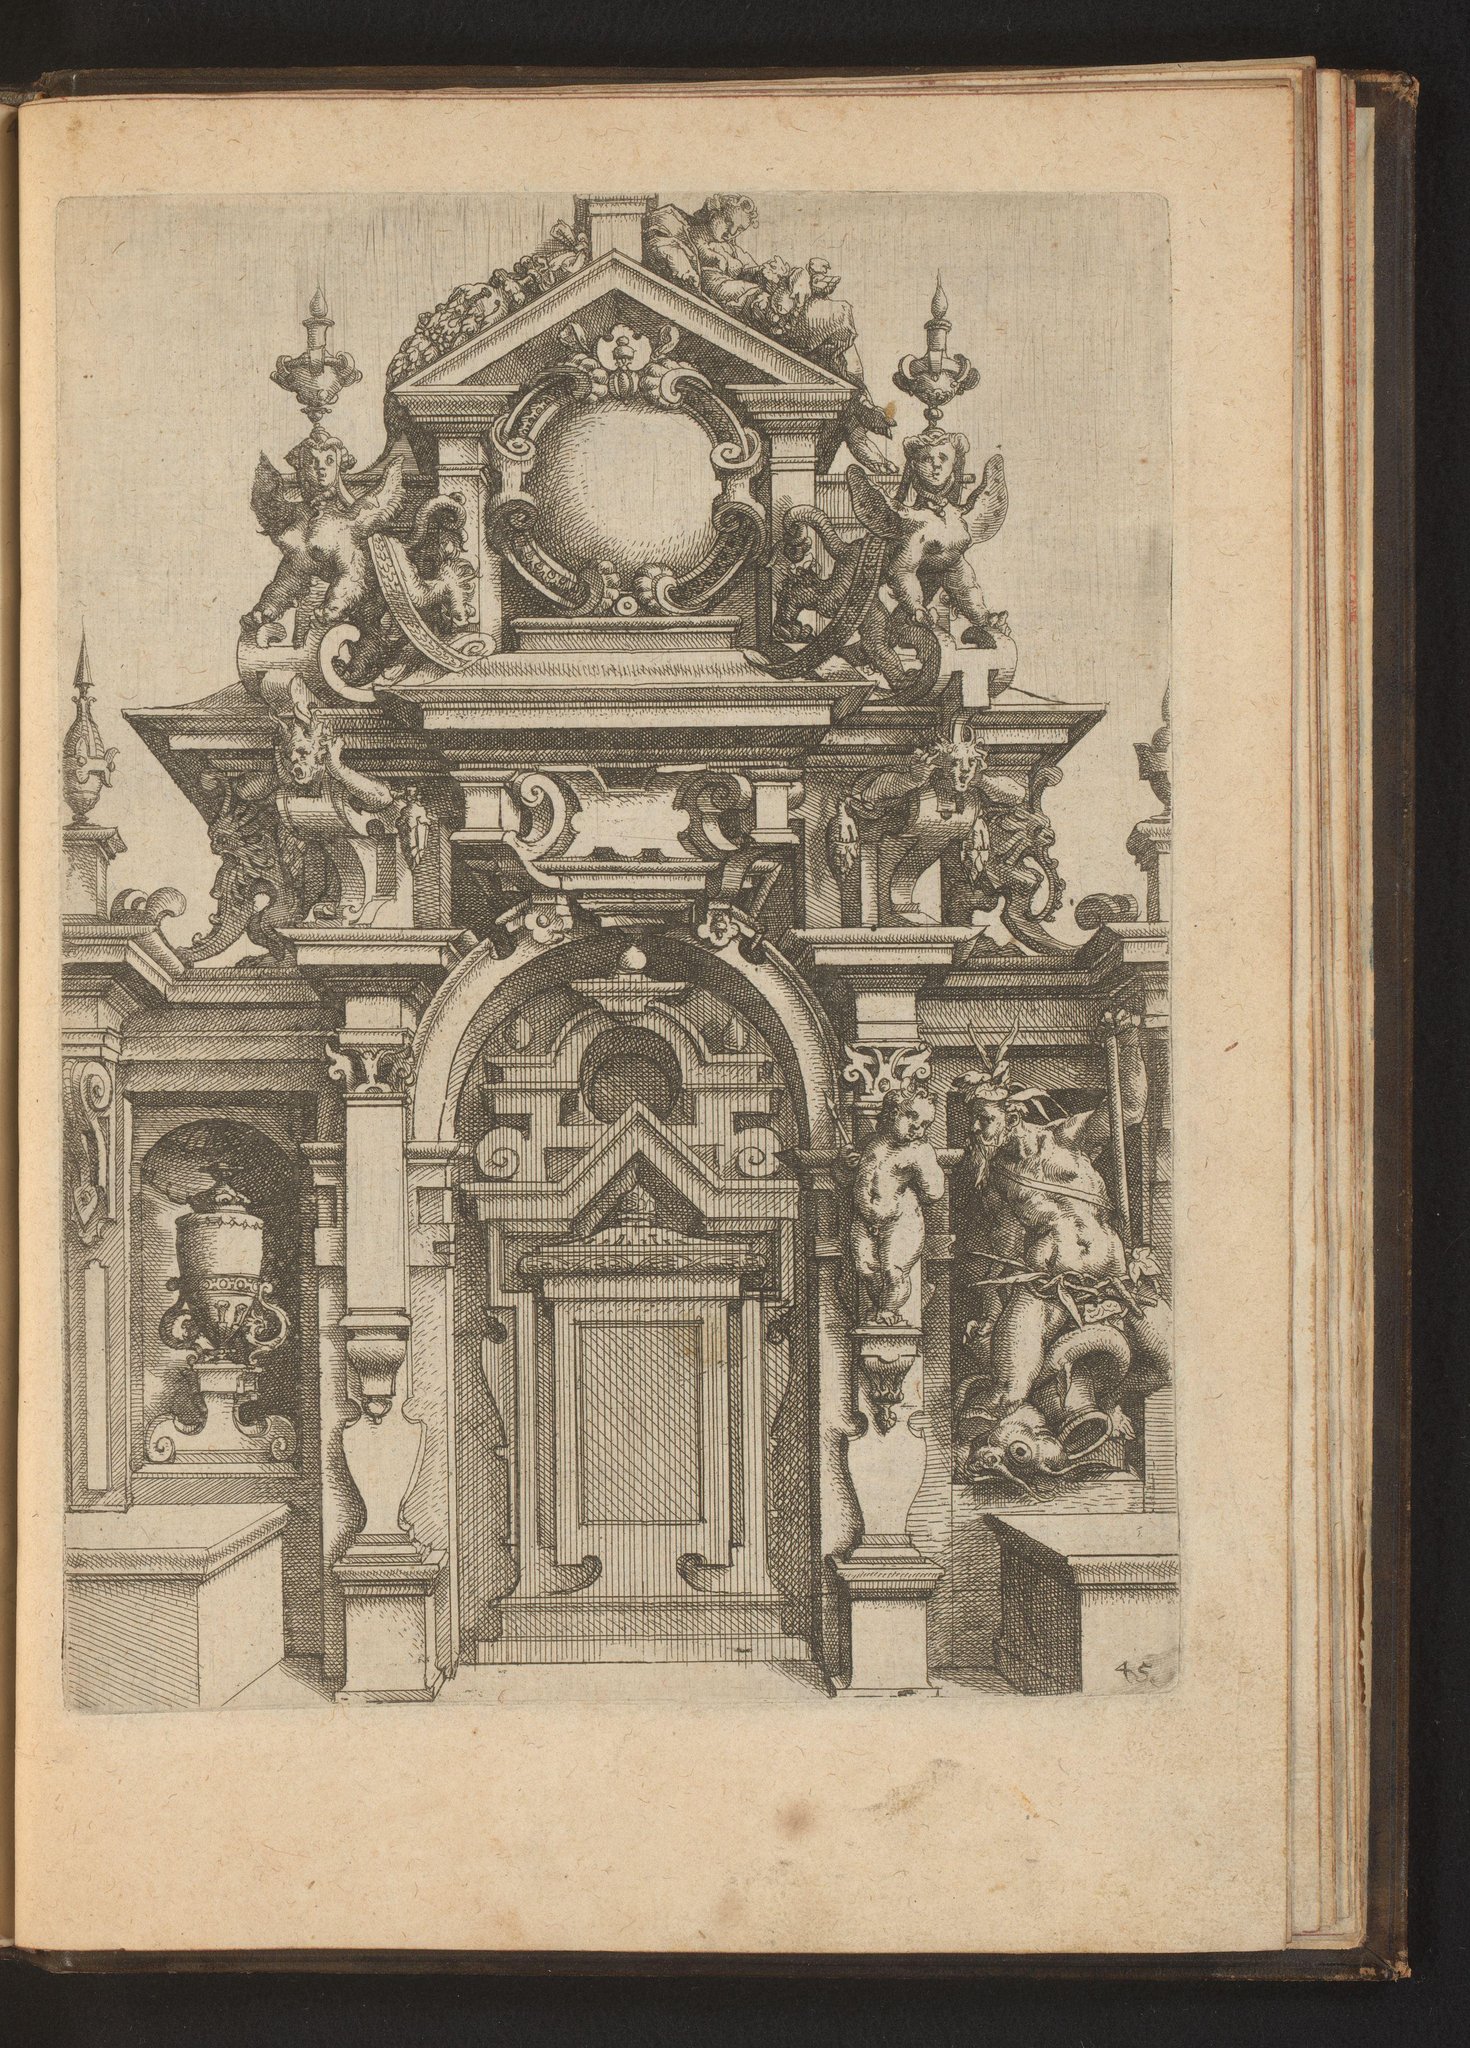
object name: page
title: Architectura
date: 1593-1595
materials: paper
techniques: etching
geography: straatsburg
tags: parts of church exterior and annexes: portal, ornament ~ hybrid beings; human and animal forms mixed, ornament derived from architectural details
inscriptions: collector's mark: Lugt 2228, collector's mark: Lugt 2760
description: Prent gebruikt in: Dietterlin, Wendel (I). Wendel Dietterlin, Architectura de Polstium seu Portalium ornatu uario Liber II. Straatsburg: Bernhard Jobin, 1594.